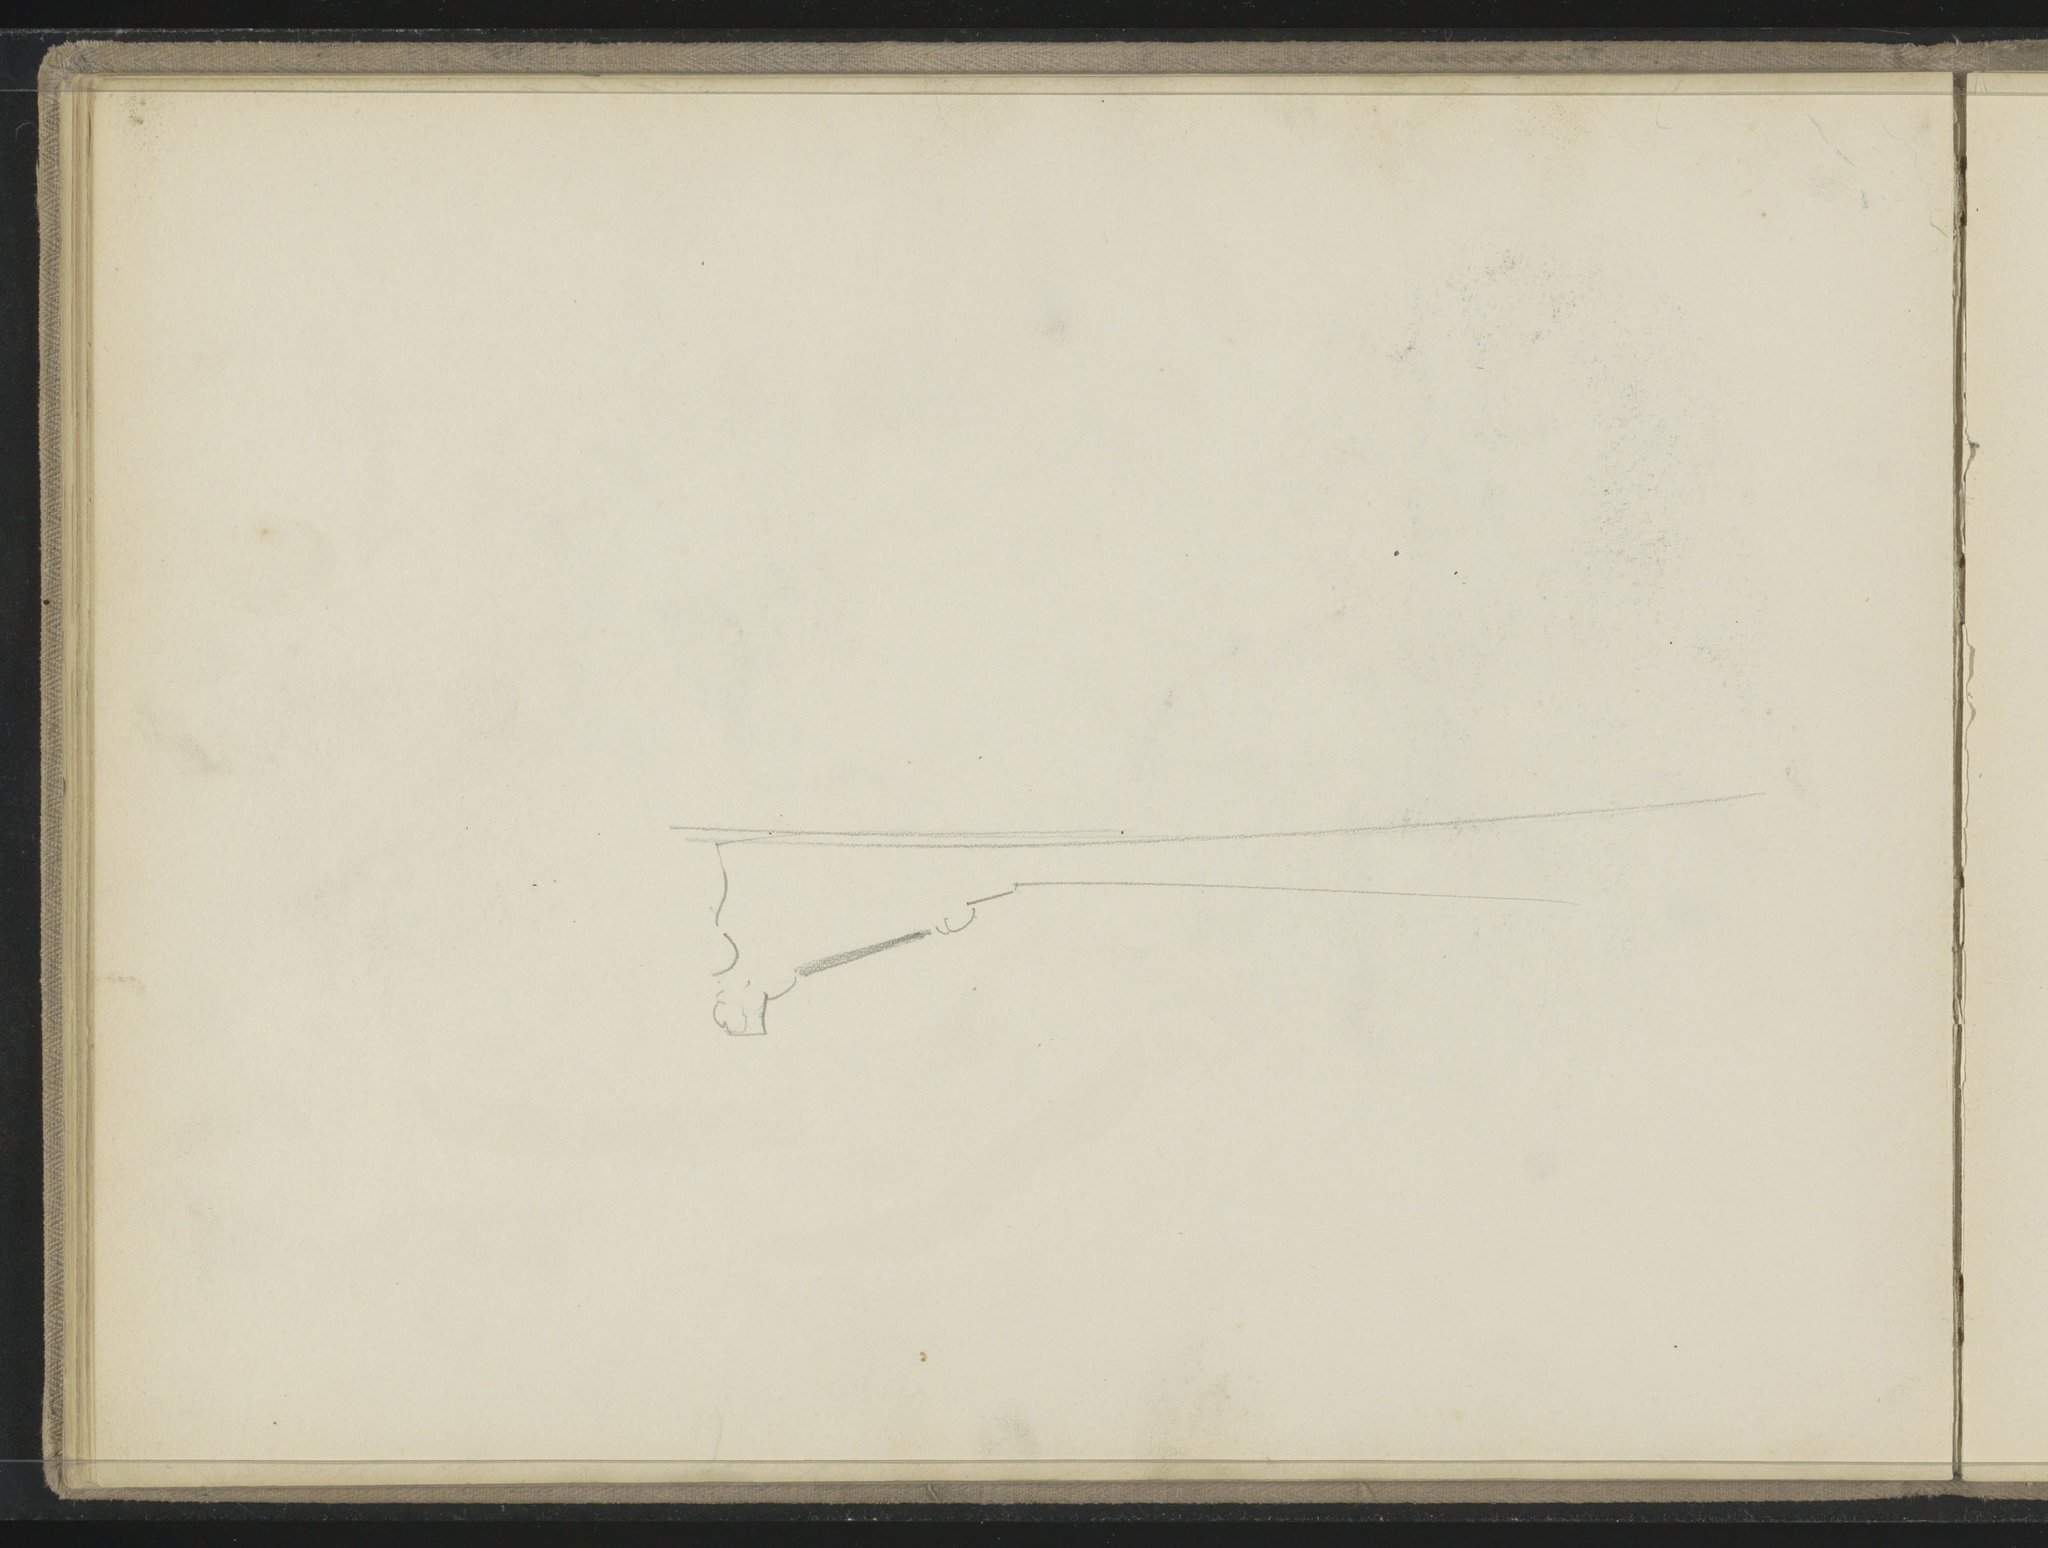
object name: sketchbook leaf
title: Architectonisch detail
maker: chris huidekooper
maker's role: draughtsman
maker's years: 1878-1939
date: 1895-1896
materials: paper, pencil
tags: architectural detail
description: Blad 29 verso uit een schetsboek met 32 bladen.